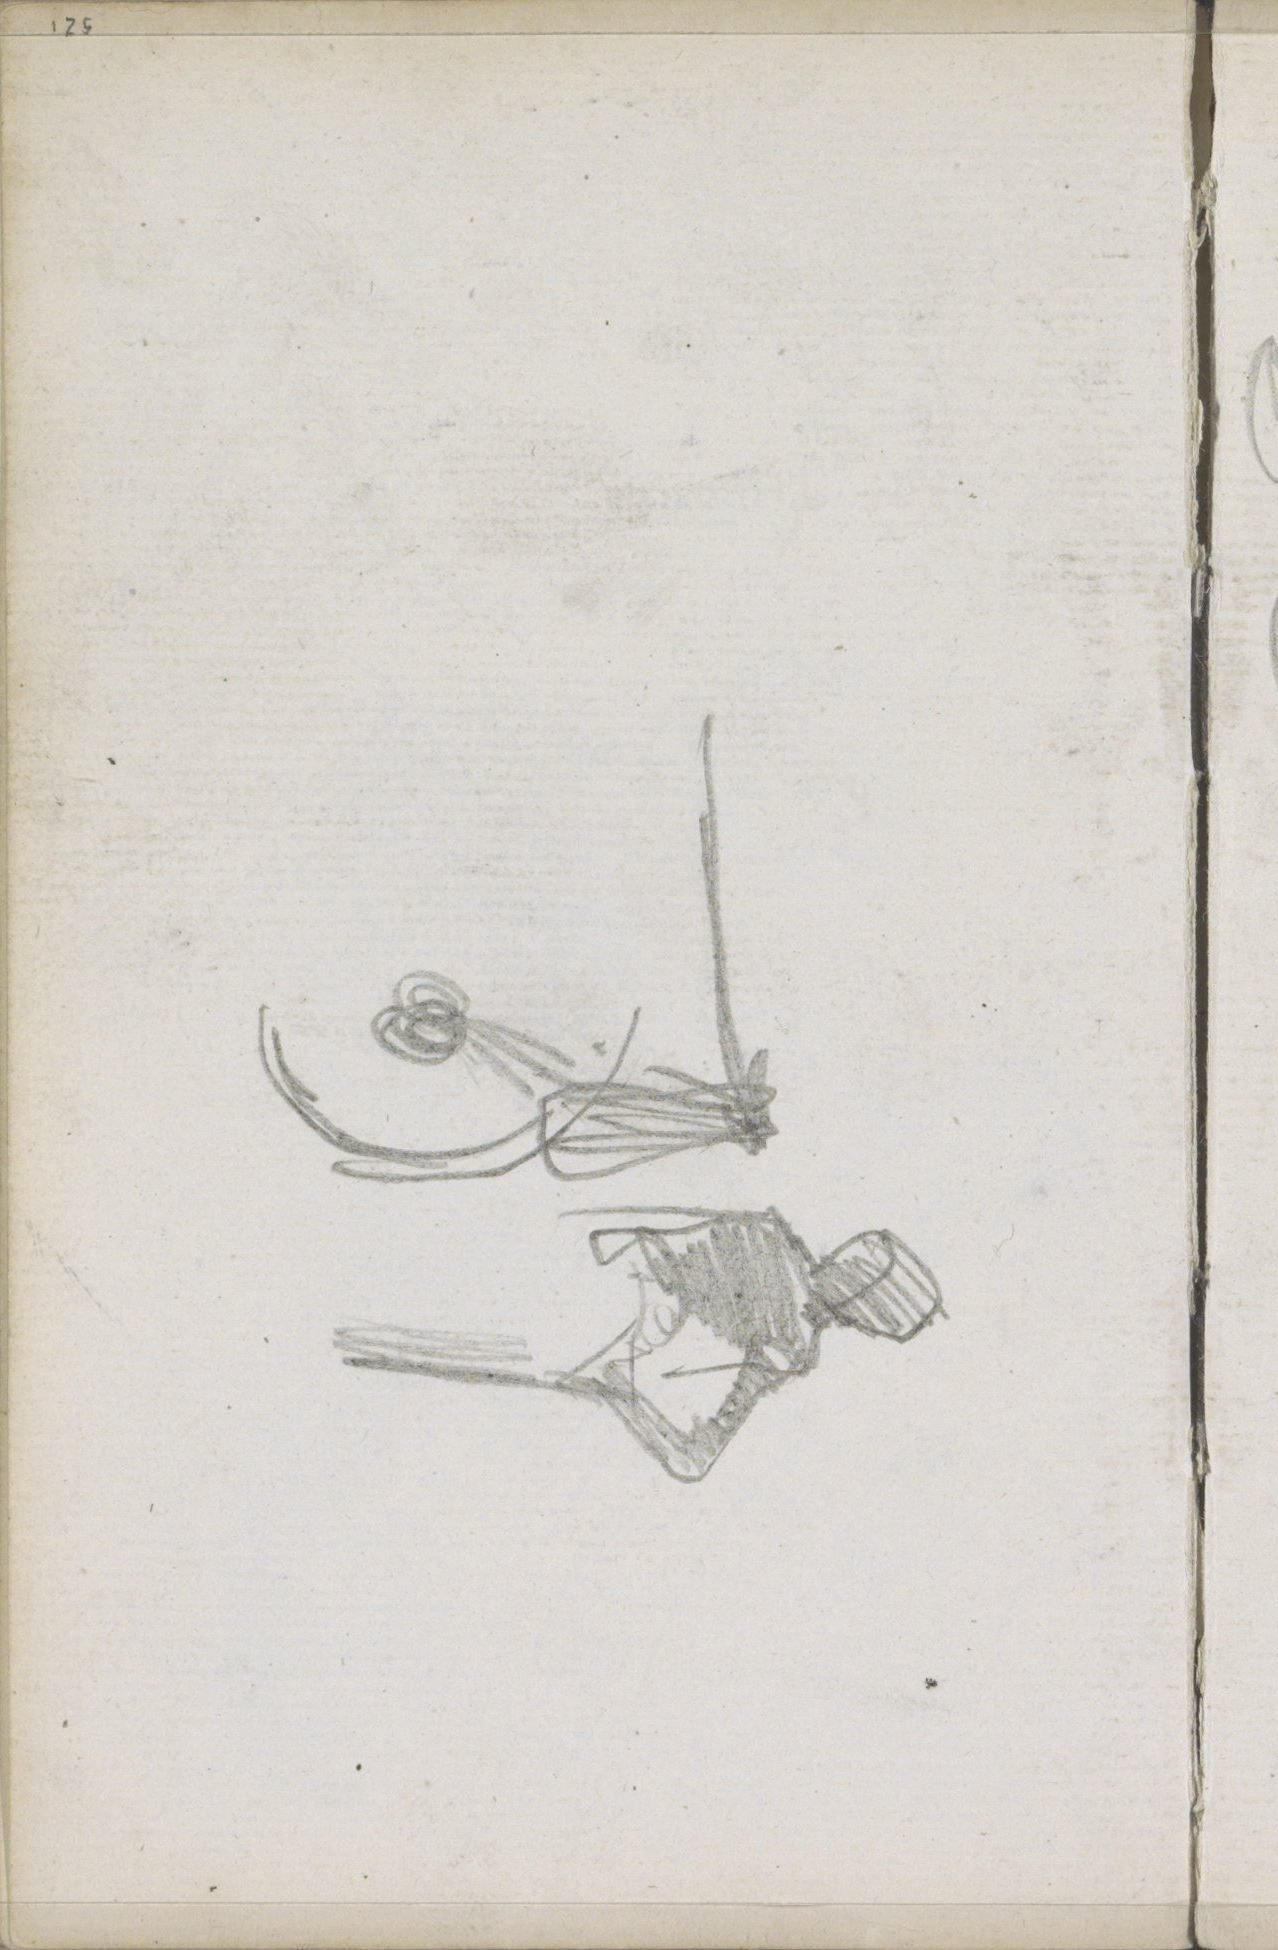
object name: sketchbook leaf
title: Boerin achter een wagen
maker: george hendrik breitner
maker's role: draughtsman, painter, print maker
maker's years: 1857-1923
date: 1884-1886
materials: paper, pencil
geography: drenthe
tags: farmers - aa - female farmer, farmer's wife, (farm) wagon, freight wagon, cart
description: Pagina 125 uit een schetsboek met 67 bladen vervaardigd in Drenthe.